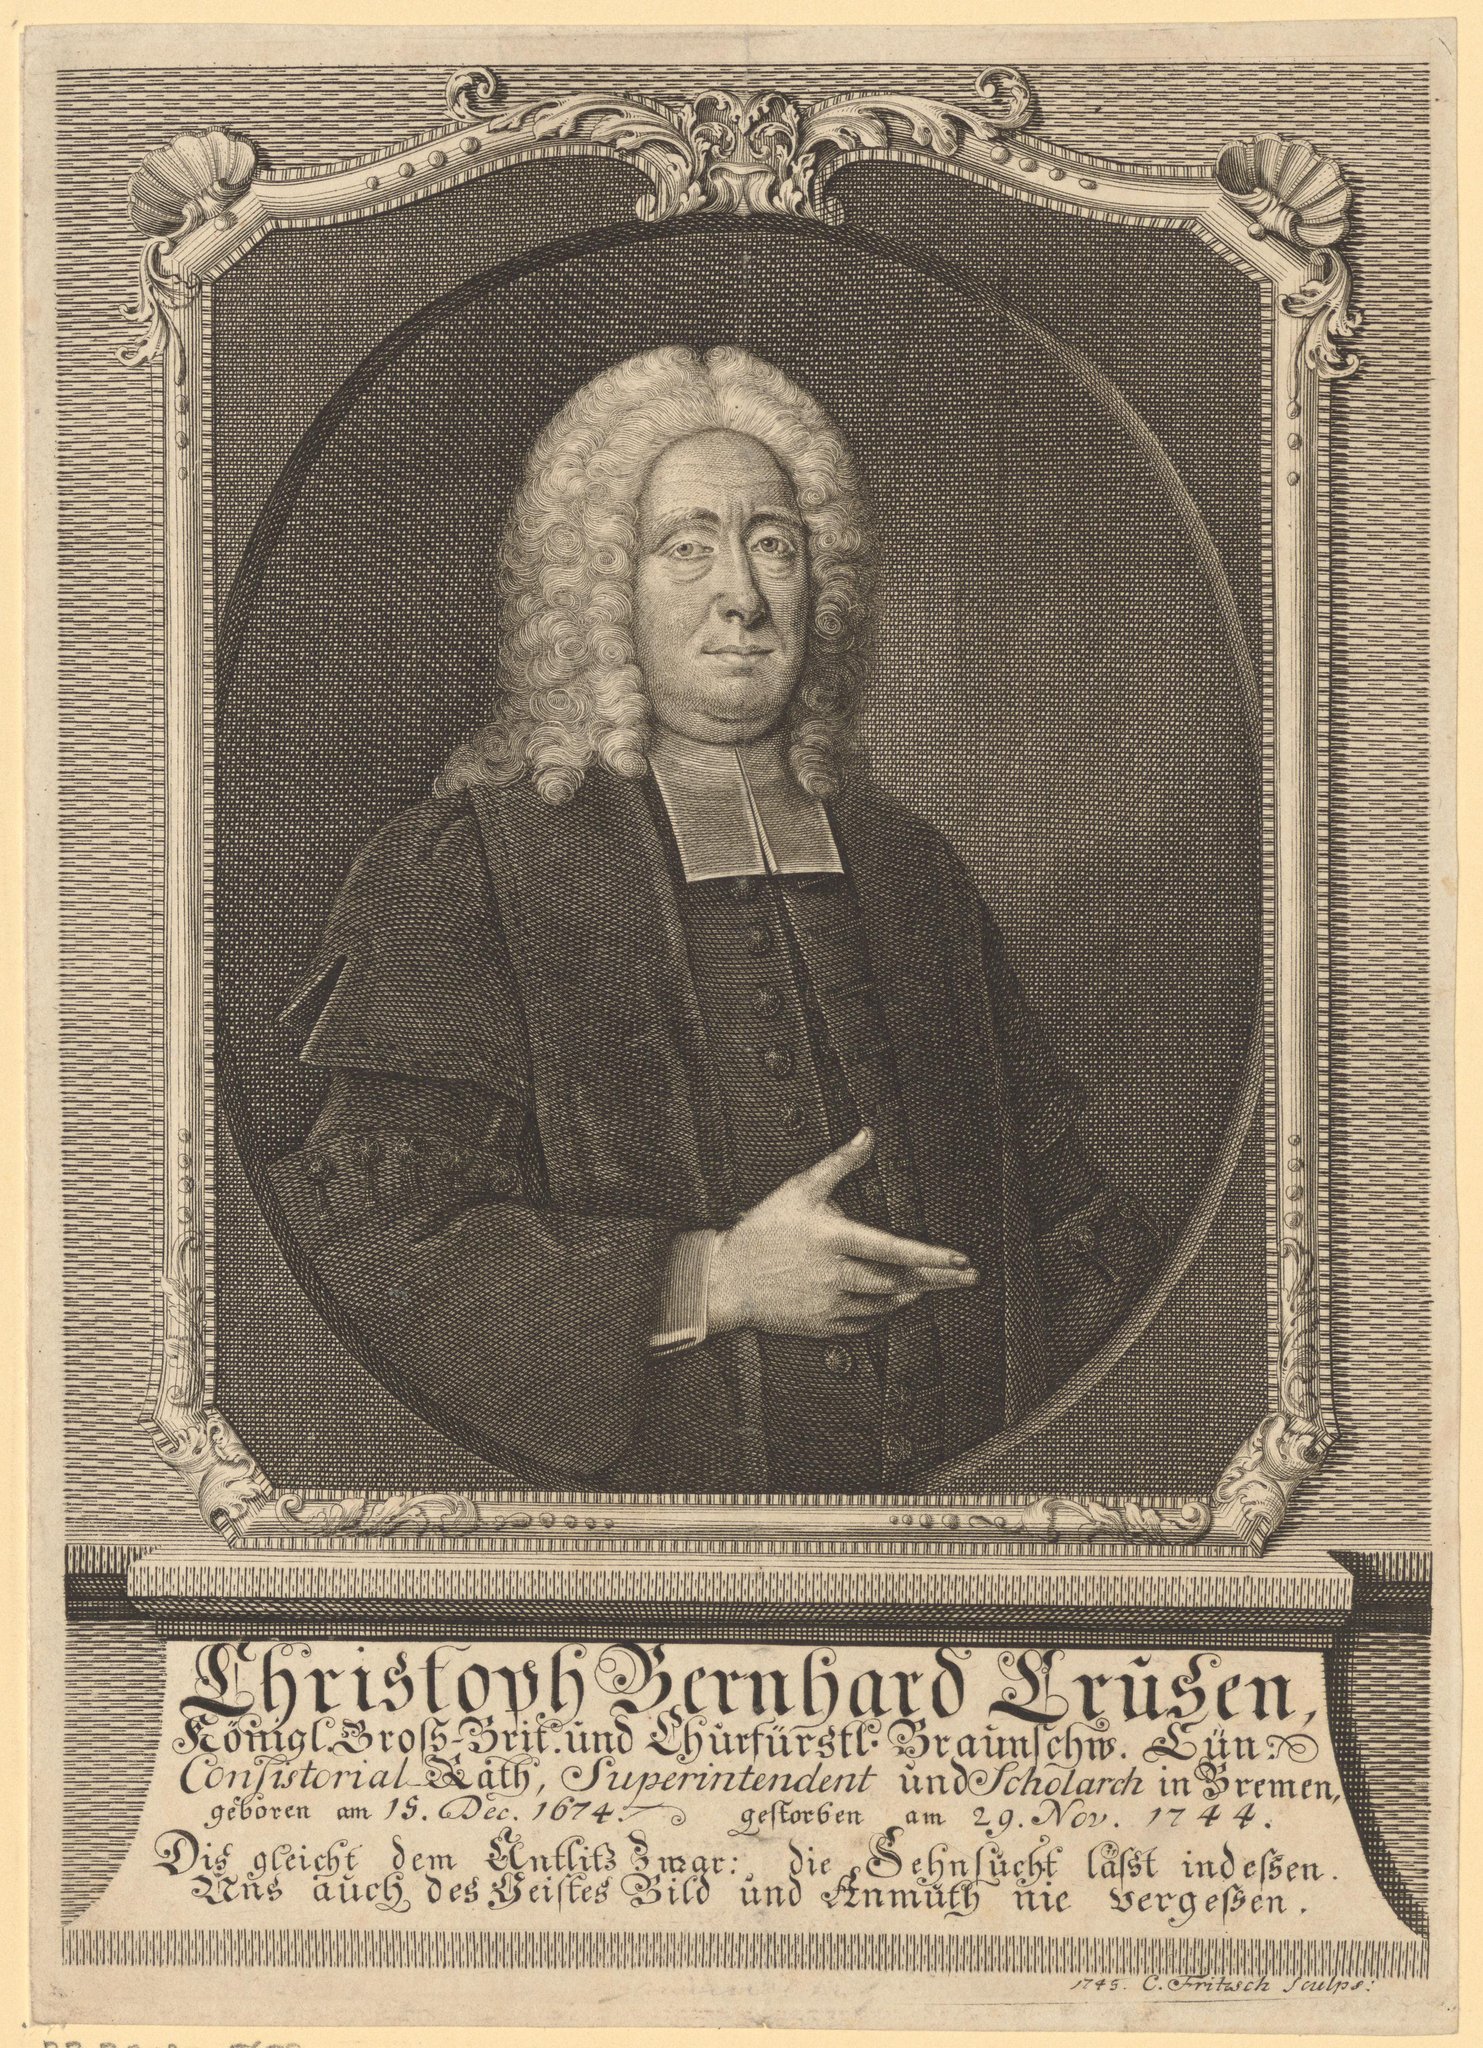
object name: print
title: Portret van Christoph Bernhard Cruse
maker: christian friedrich fritzsch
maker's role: print maker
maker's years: 1719-1774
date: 1745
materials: paper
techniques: engraving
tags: historical persons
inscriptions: date